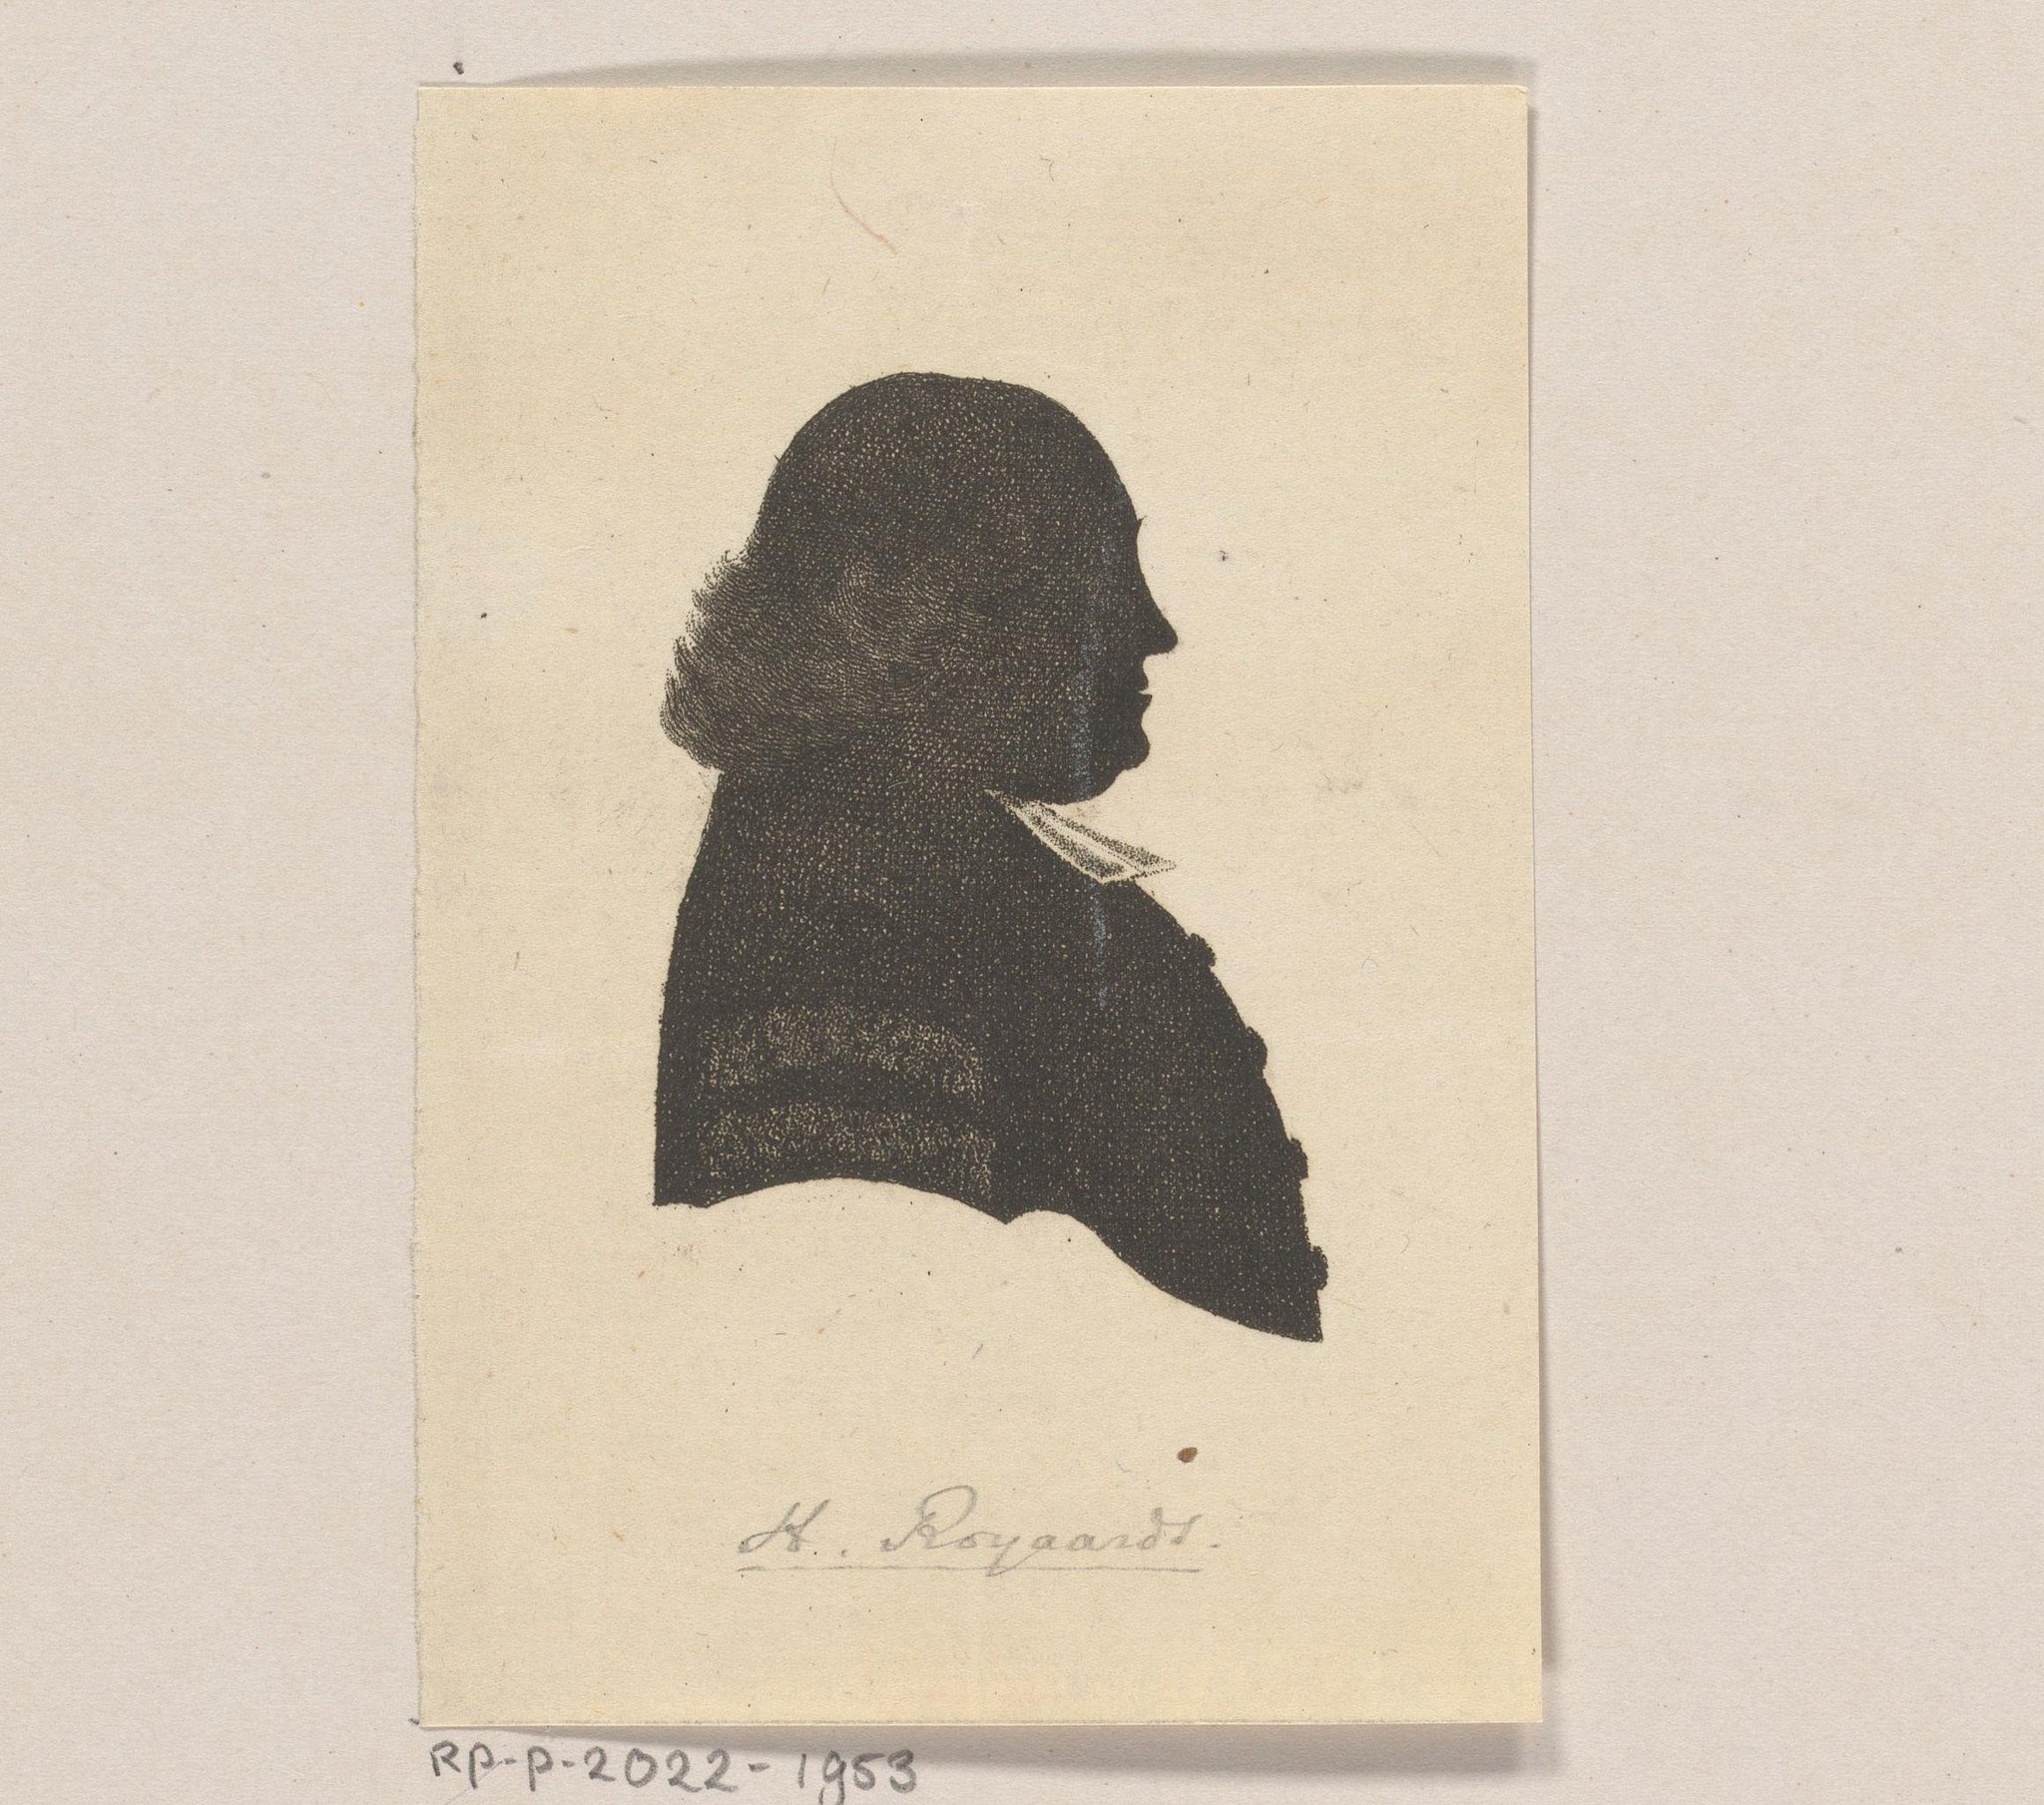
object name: print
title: Silhouetportret van Hermannus Royaards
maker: Anonymous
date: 1793-1850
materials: paper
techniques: etching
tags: utrecht, theologian, historical persons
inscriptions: name: ‘H. Royaards.’